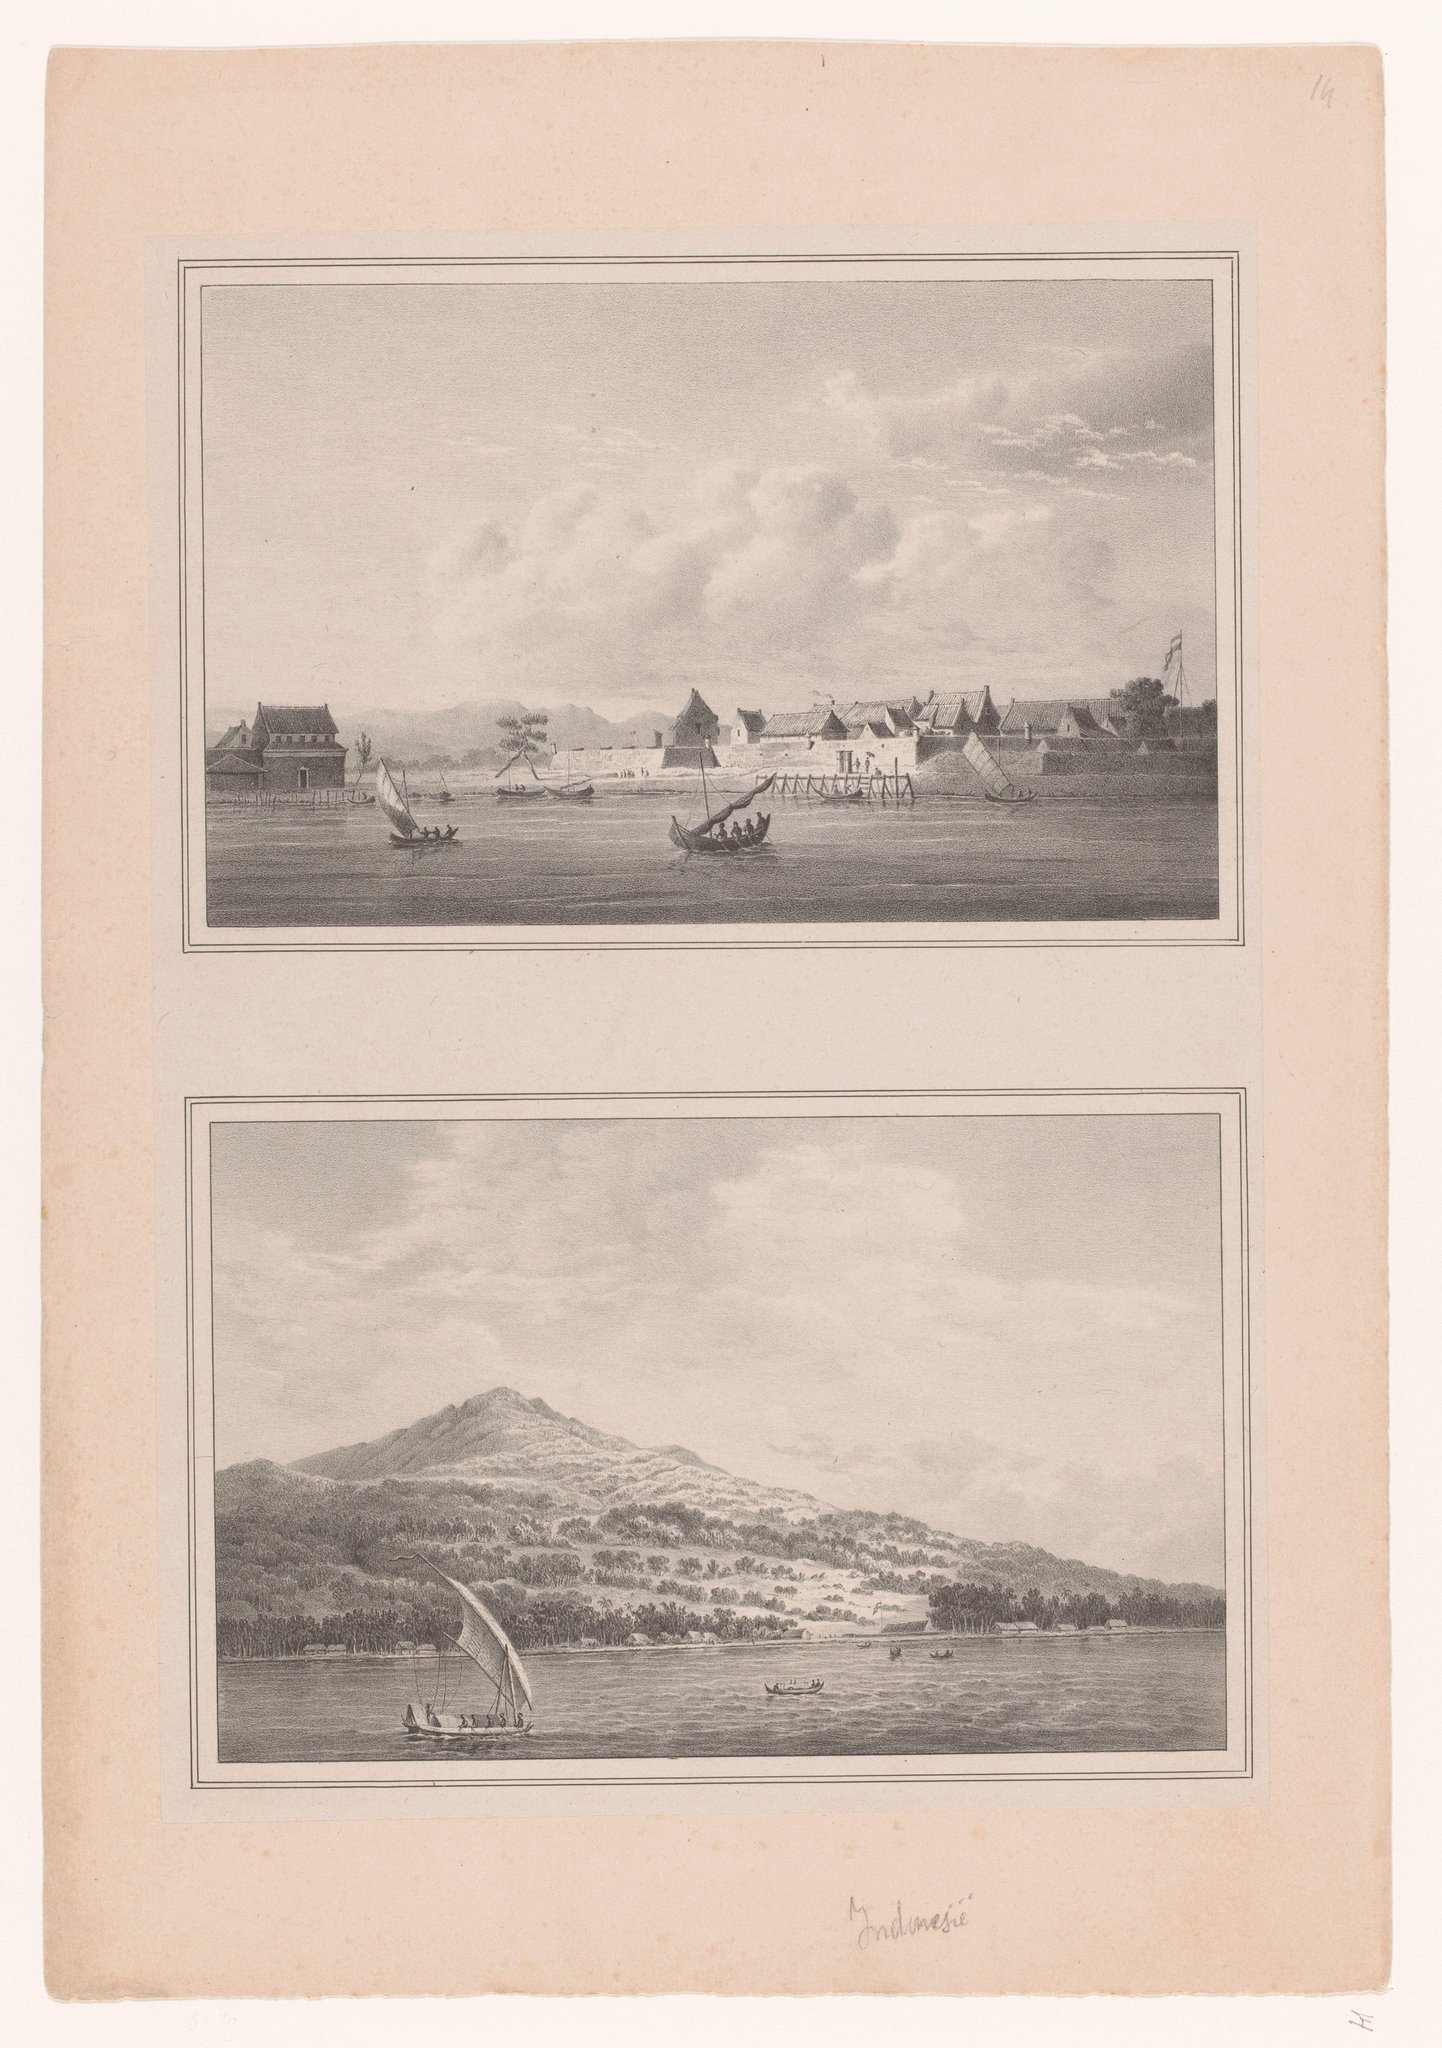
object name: print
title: Twee gezichten op eilanden in Indonesië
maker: Anonymous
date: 1830-1880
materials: paper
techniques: lithograph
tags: island (in tropical and sub-tropical regions), indonesia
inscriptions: collector's mark: Lugt 2760, collector's mark: Lugt 2228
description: Twee gezichten, vanaf zee gezien, op eilanden in Indonesië. Op de bovenste afbeelding een ommuurde vesting of handelspost met westerse gebouwen, de Nederlandse vlag rechts. Kleine zeilboten op zee. De onderste afbeelding van een bergachtig landschap met enkele gebouwen aan het strand.